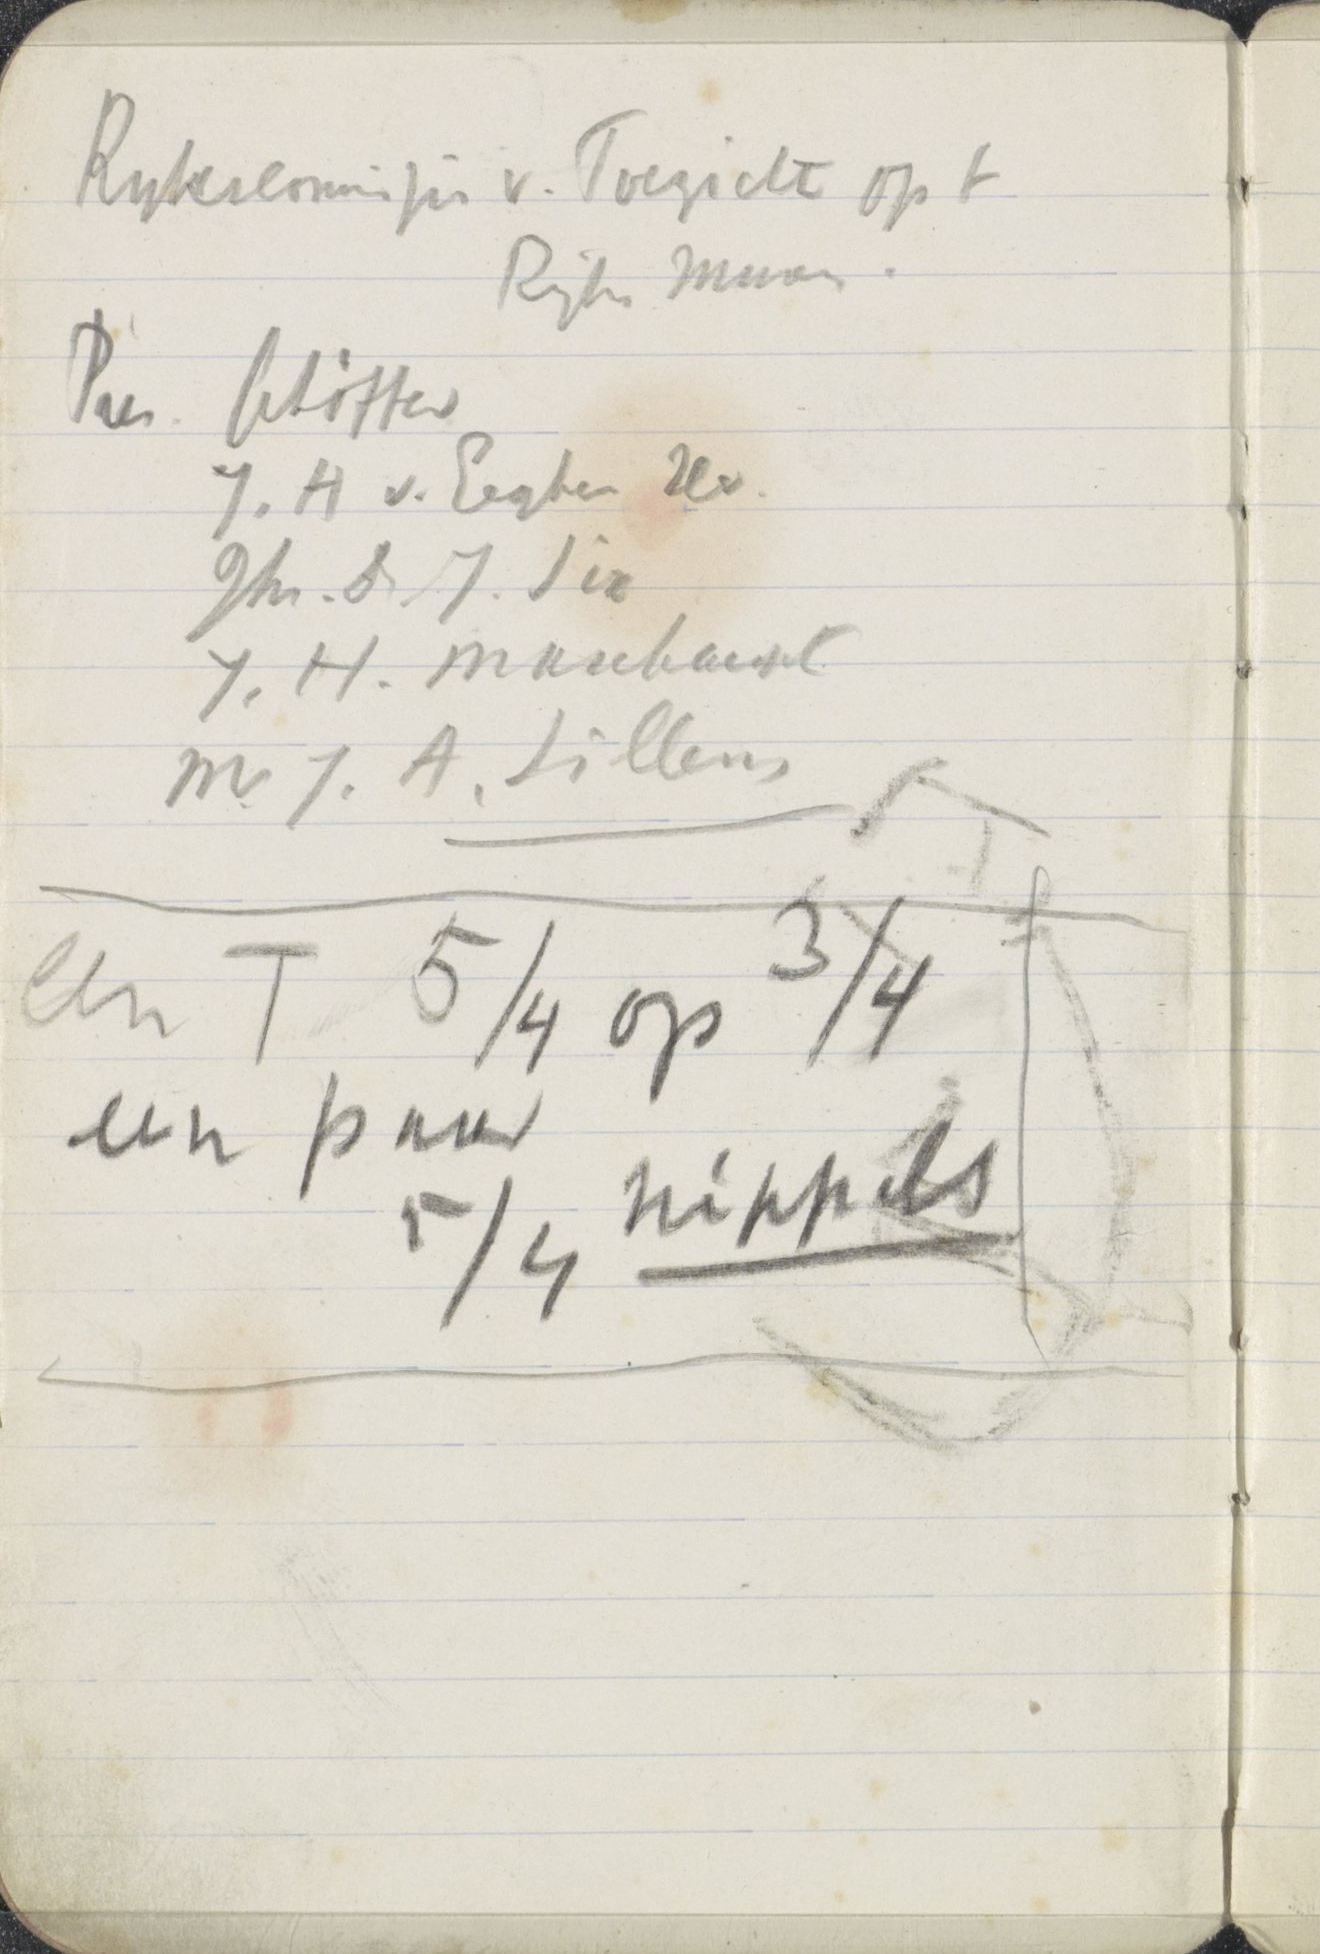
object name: sketchbook leaf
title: Annotaties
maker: george hendrik breitner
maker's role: draughtsman, painter, print maker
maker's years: 1857-1923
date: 1896-1897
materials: chalk, pencil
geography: amsterdam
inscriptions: annotation: ‘Rijkscommissie v. Toezicht op t/ Rijks Museum./ [...] Schöffer/ J.H. v. Eeghen/ Jhr. S.J. Six/ J.H. Mauba[...]/ Mr. J.A. Sillens/ [...]’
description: Pagina 3 uit een schetsboek met 39 bladen.